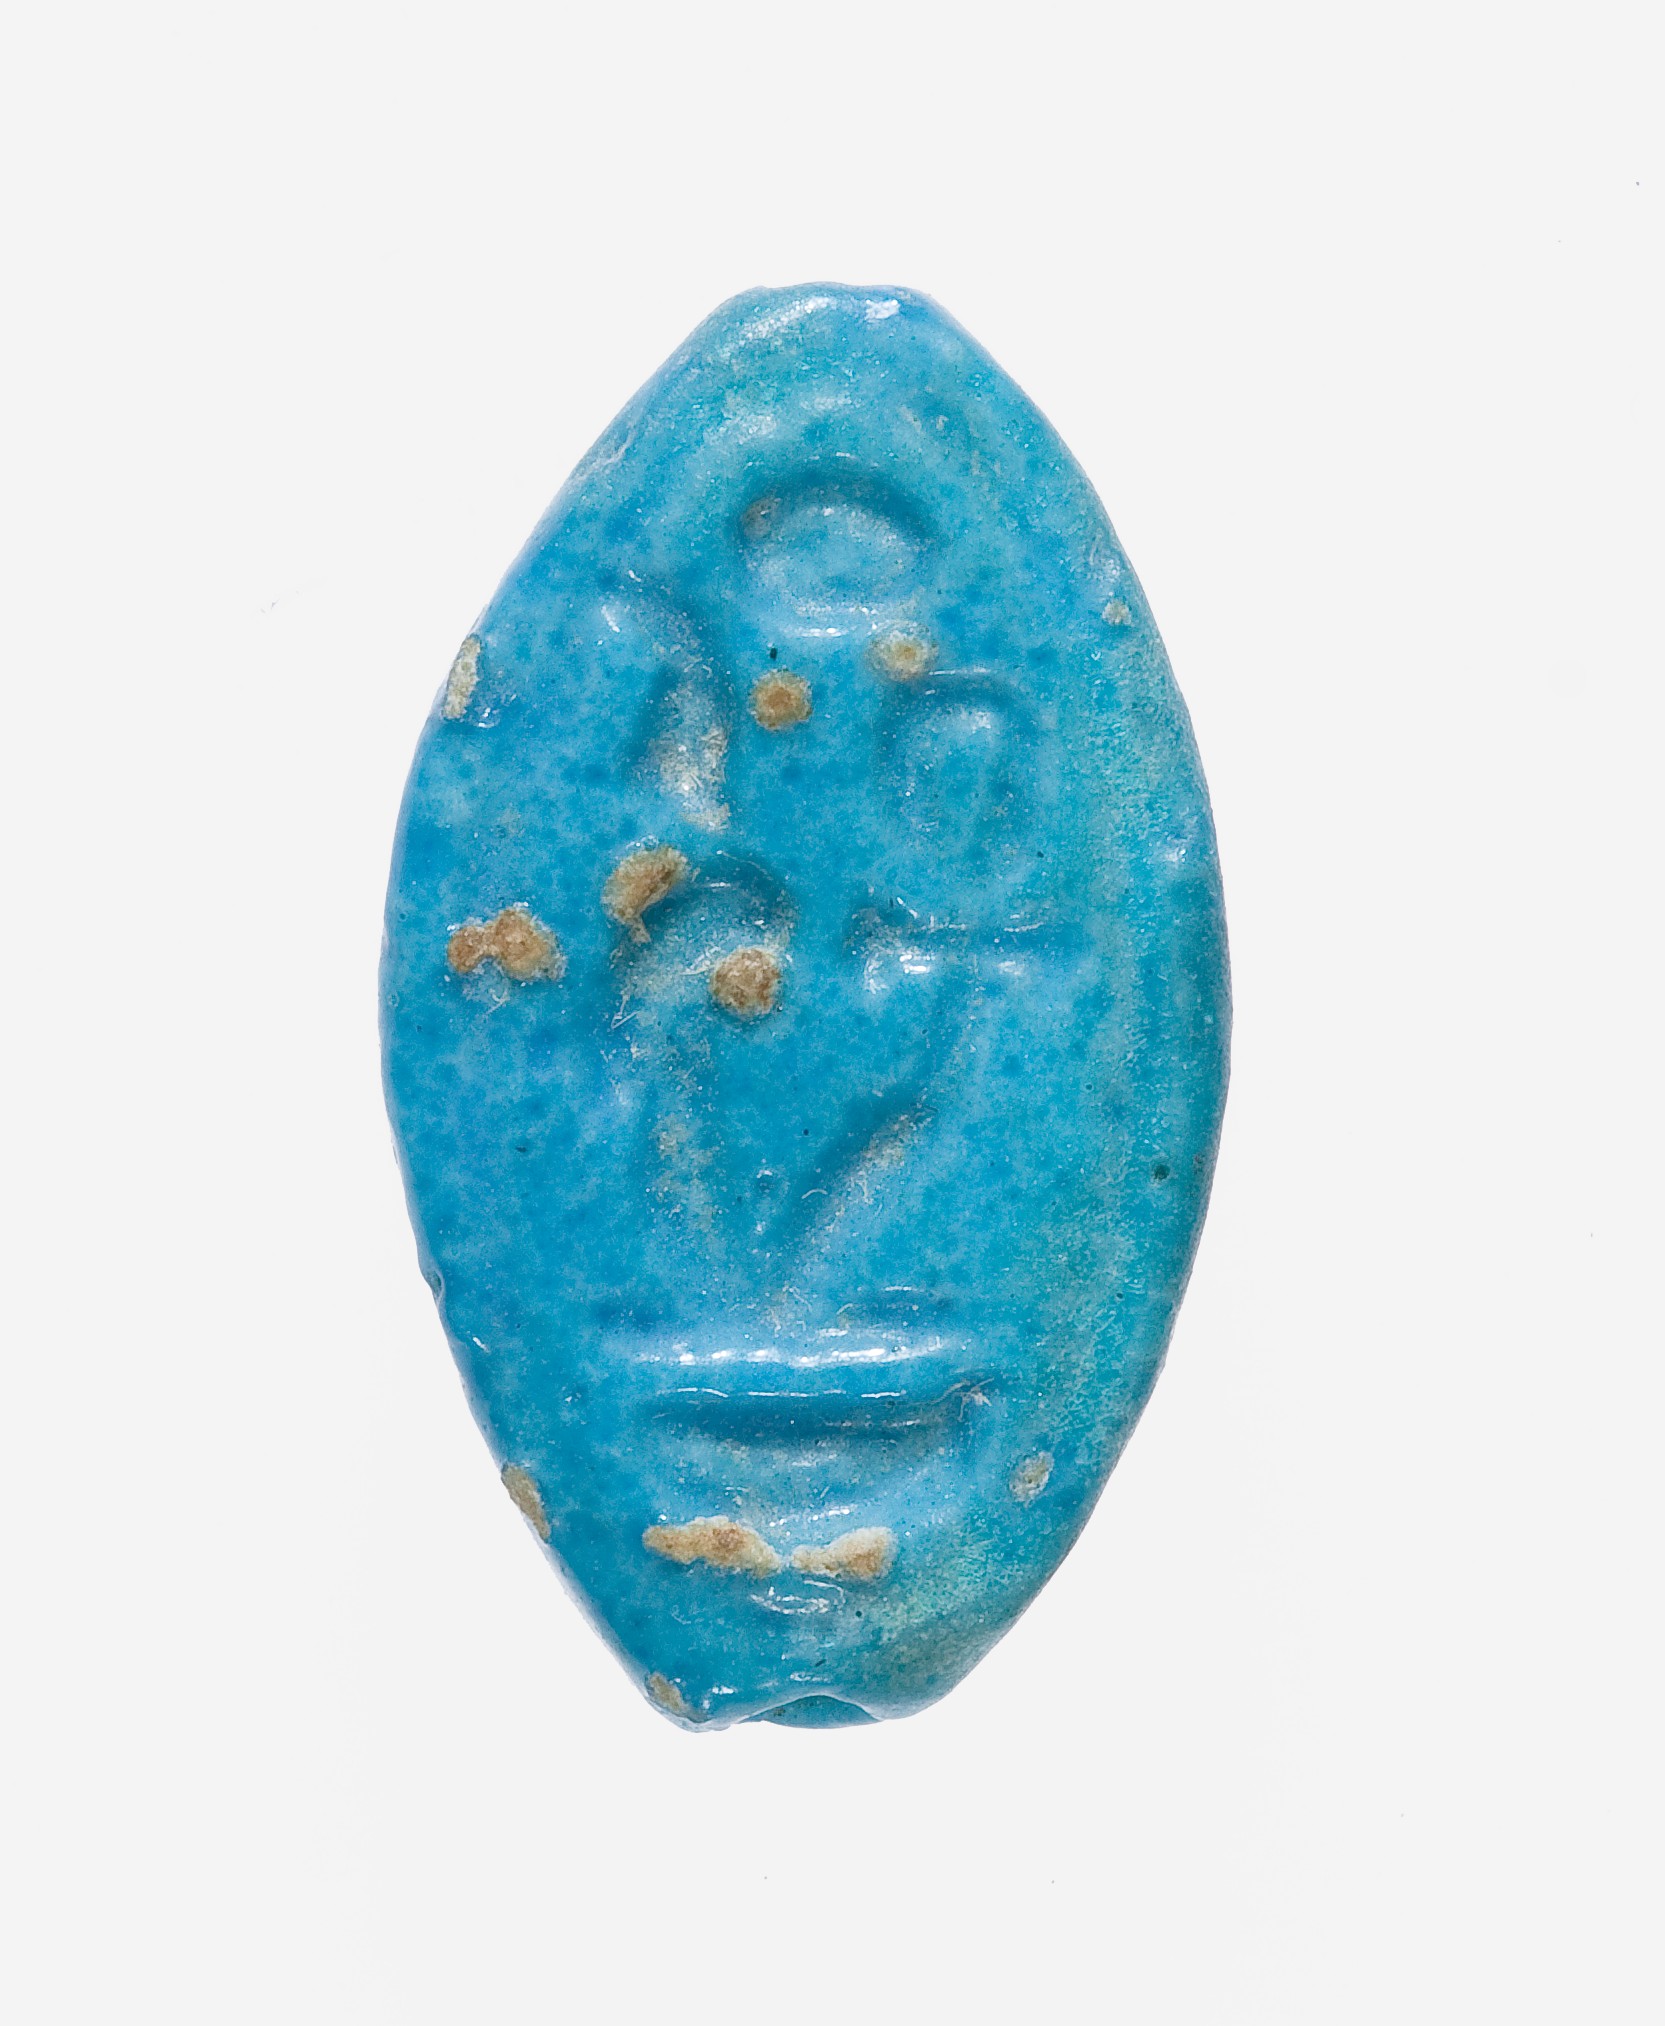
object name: cowroid, amenhotep iii, nebmaatre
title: Cowroid Stamp Seal Inscribed with the Throne Name of Amenhotep III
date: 1390-1352 BCE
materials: faience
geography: egypt